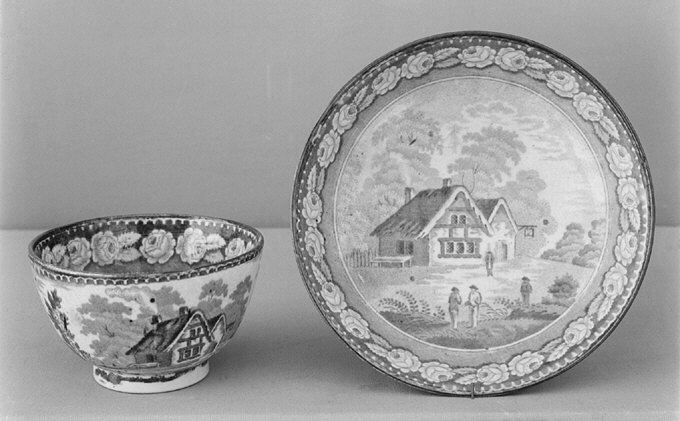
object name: cup and saucer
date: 1801-1900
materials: earthenware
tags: human figures,houses,trees